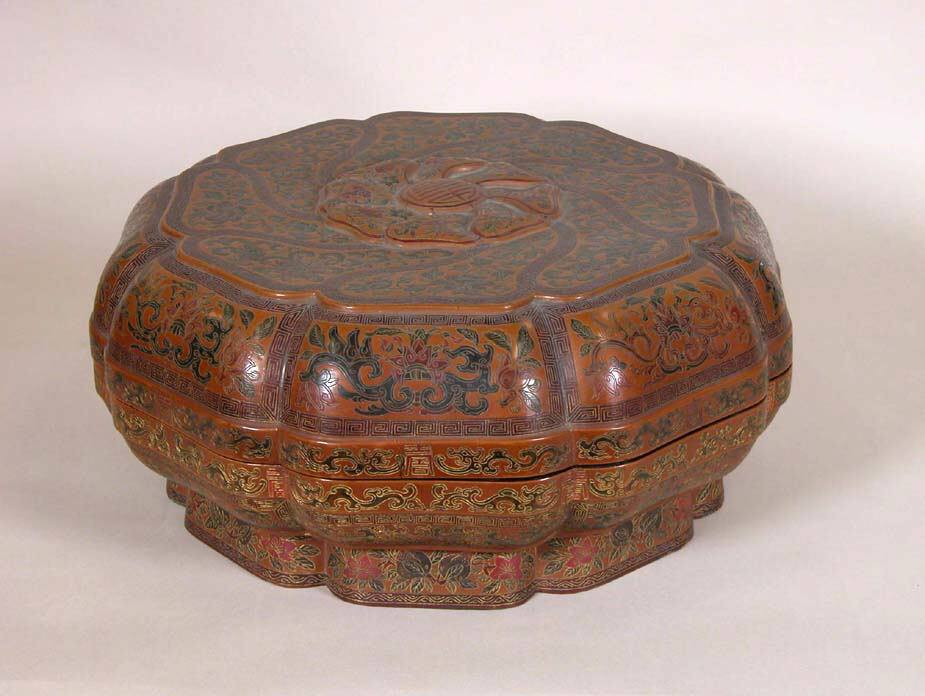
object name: box with cover and tray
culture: chinese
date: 1601-1700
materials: lacquer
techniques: carving, polish